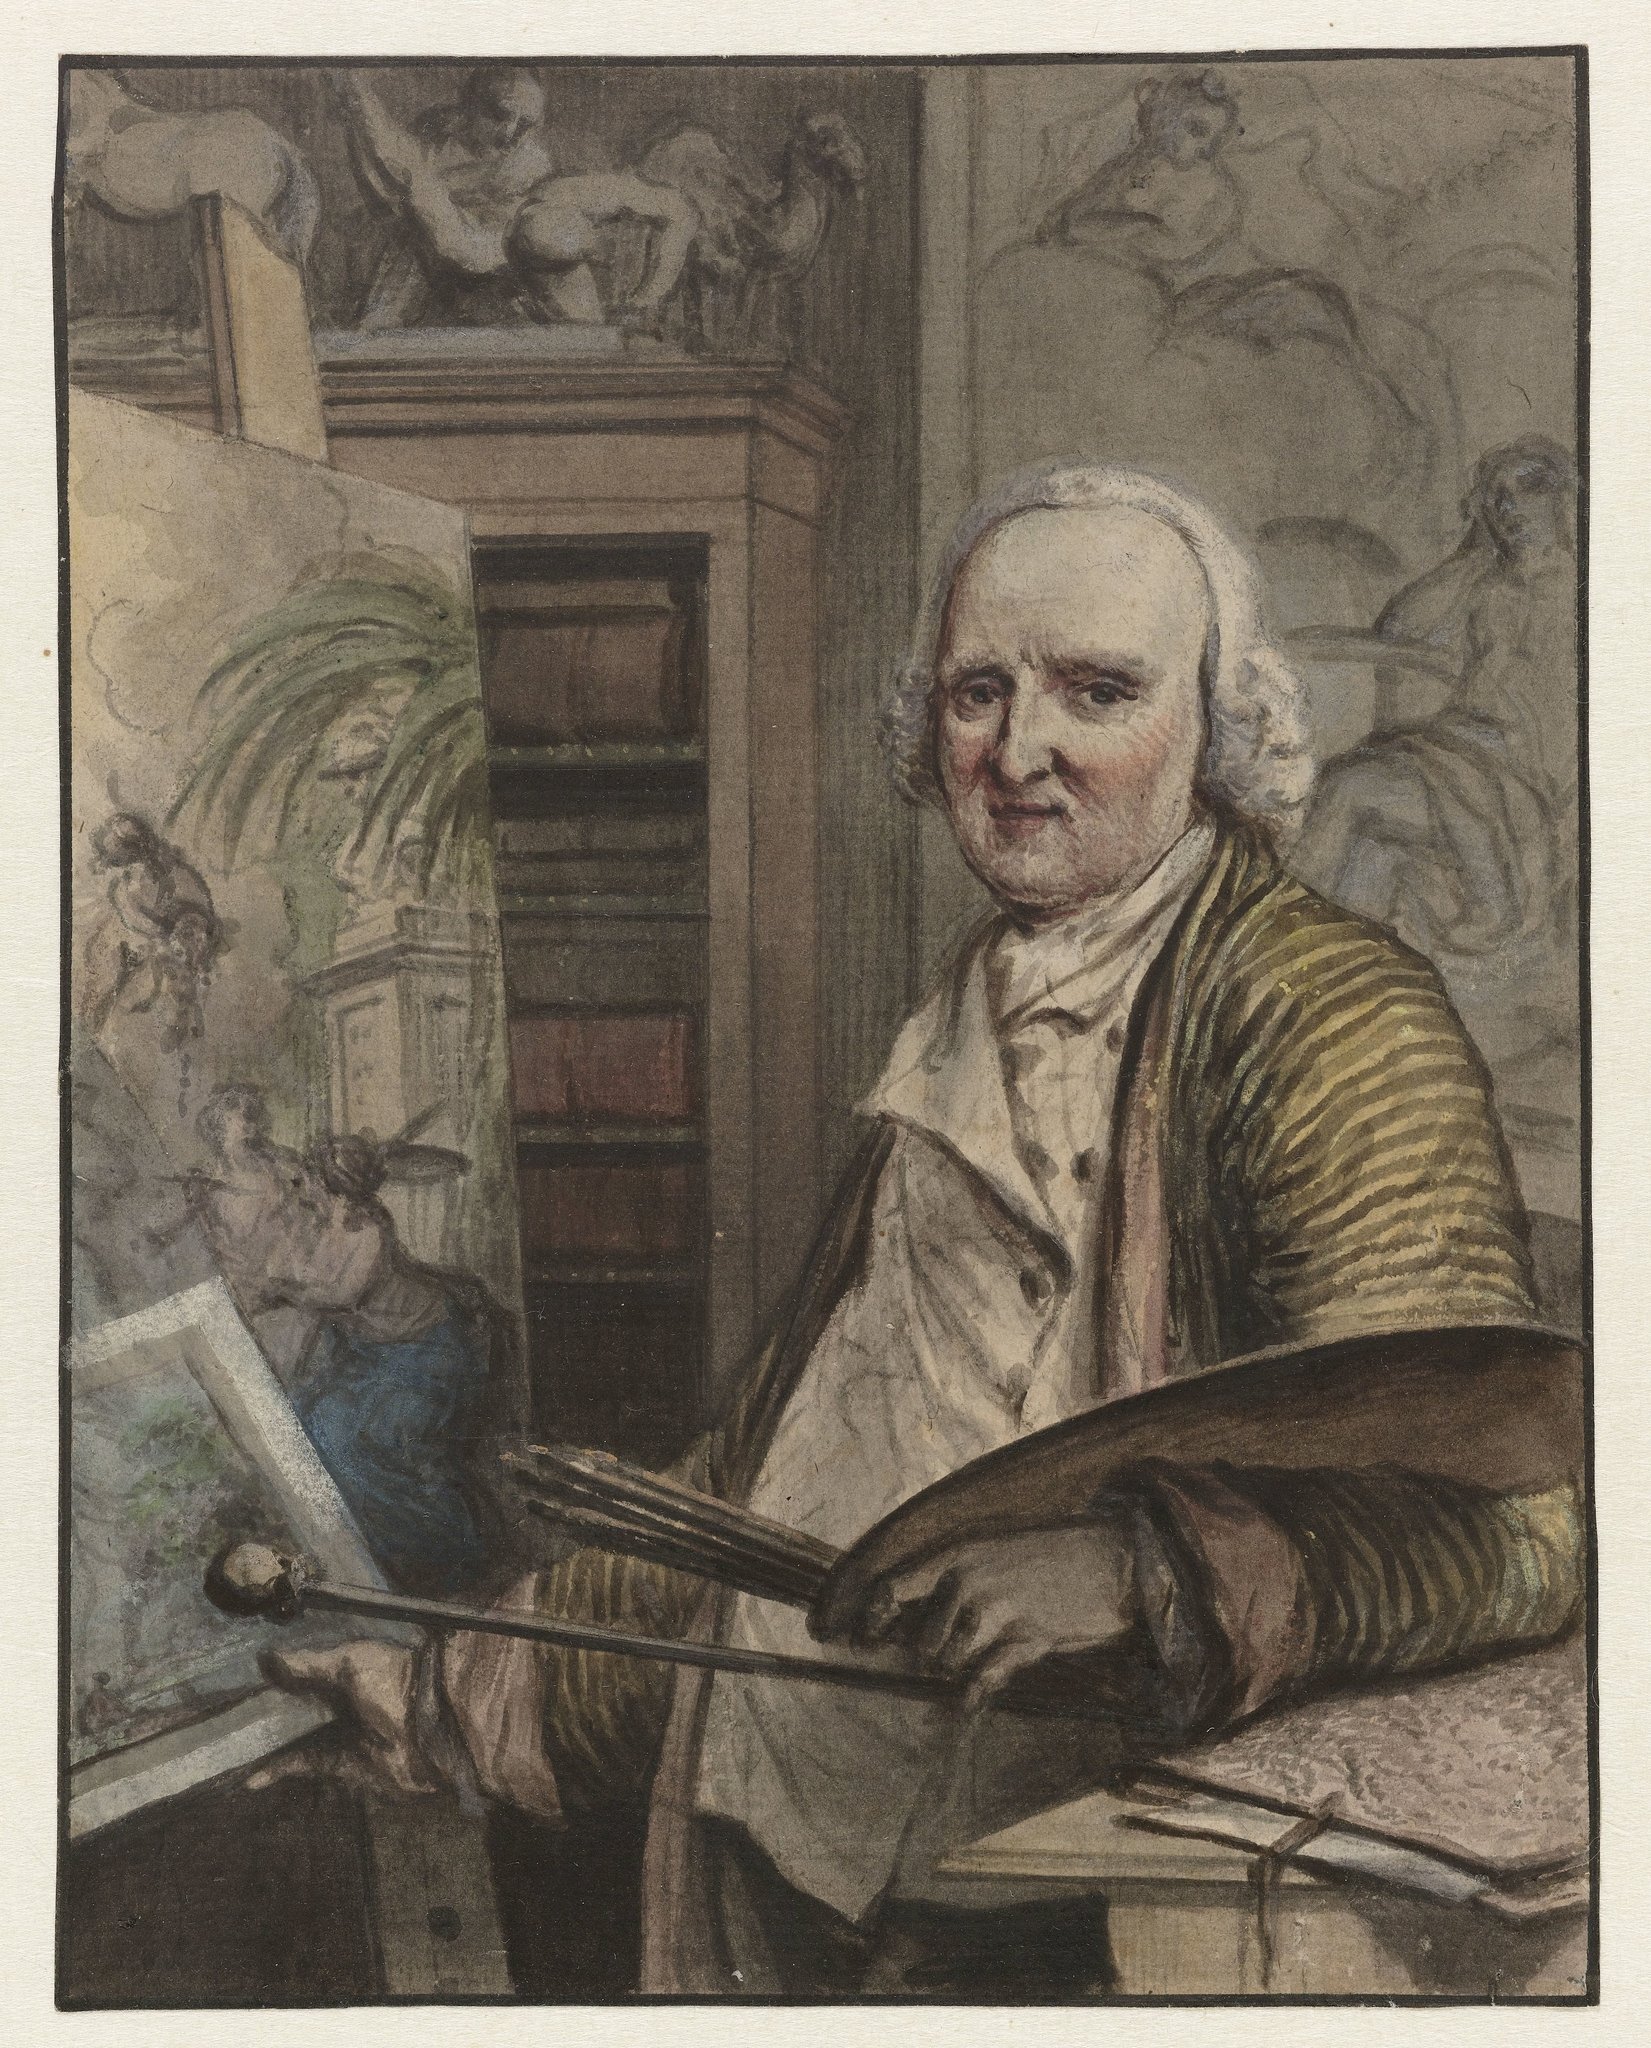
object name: watercolor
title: Zelfportret van Jurriaan Andriessen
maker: jurriaan andriessen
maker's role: draughtsman, painter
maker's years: 1742-1819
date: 1799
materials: chalk, paper, watercolor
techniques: brush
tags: amsterdam, jurriaan andriessen, historical persons, portrait, self-portrait of painter, portrait, self-portrait of artist